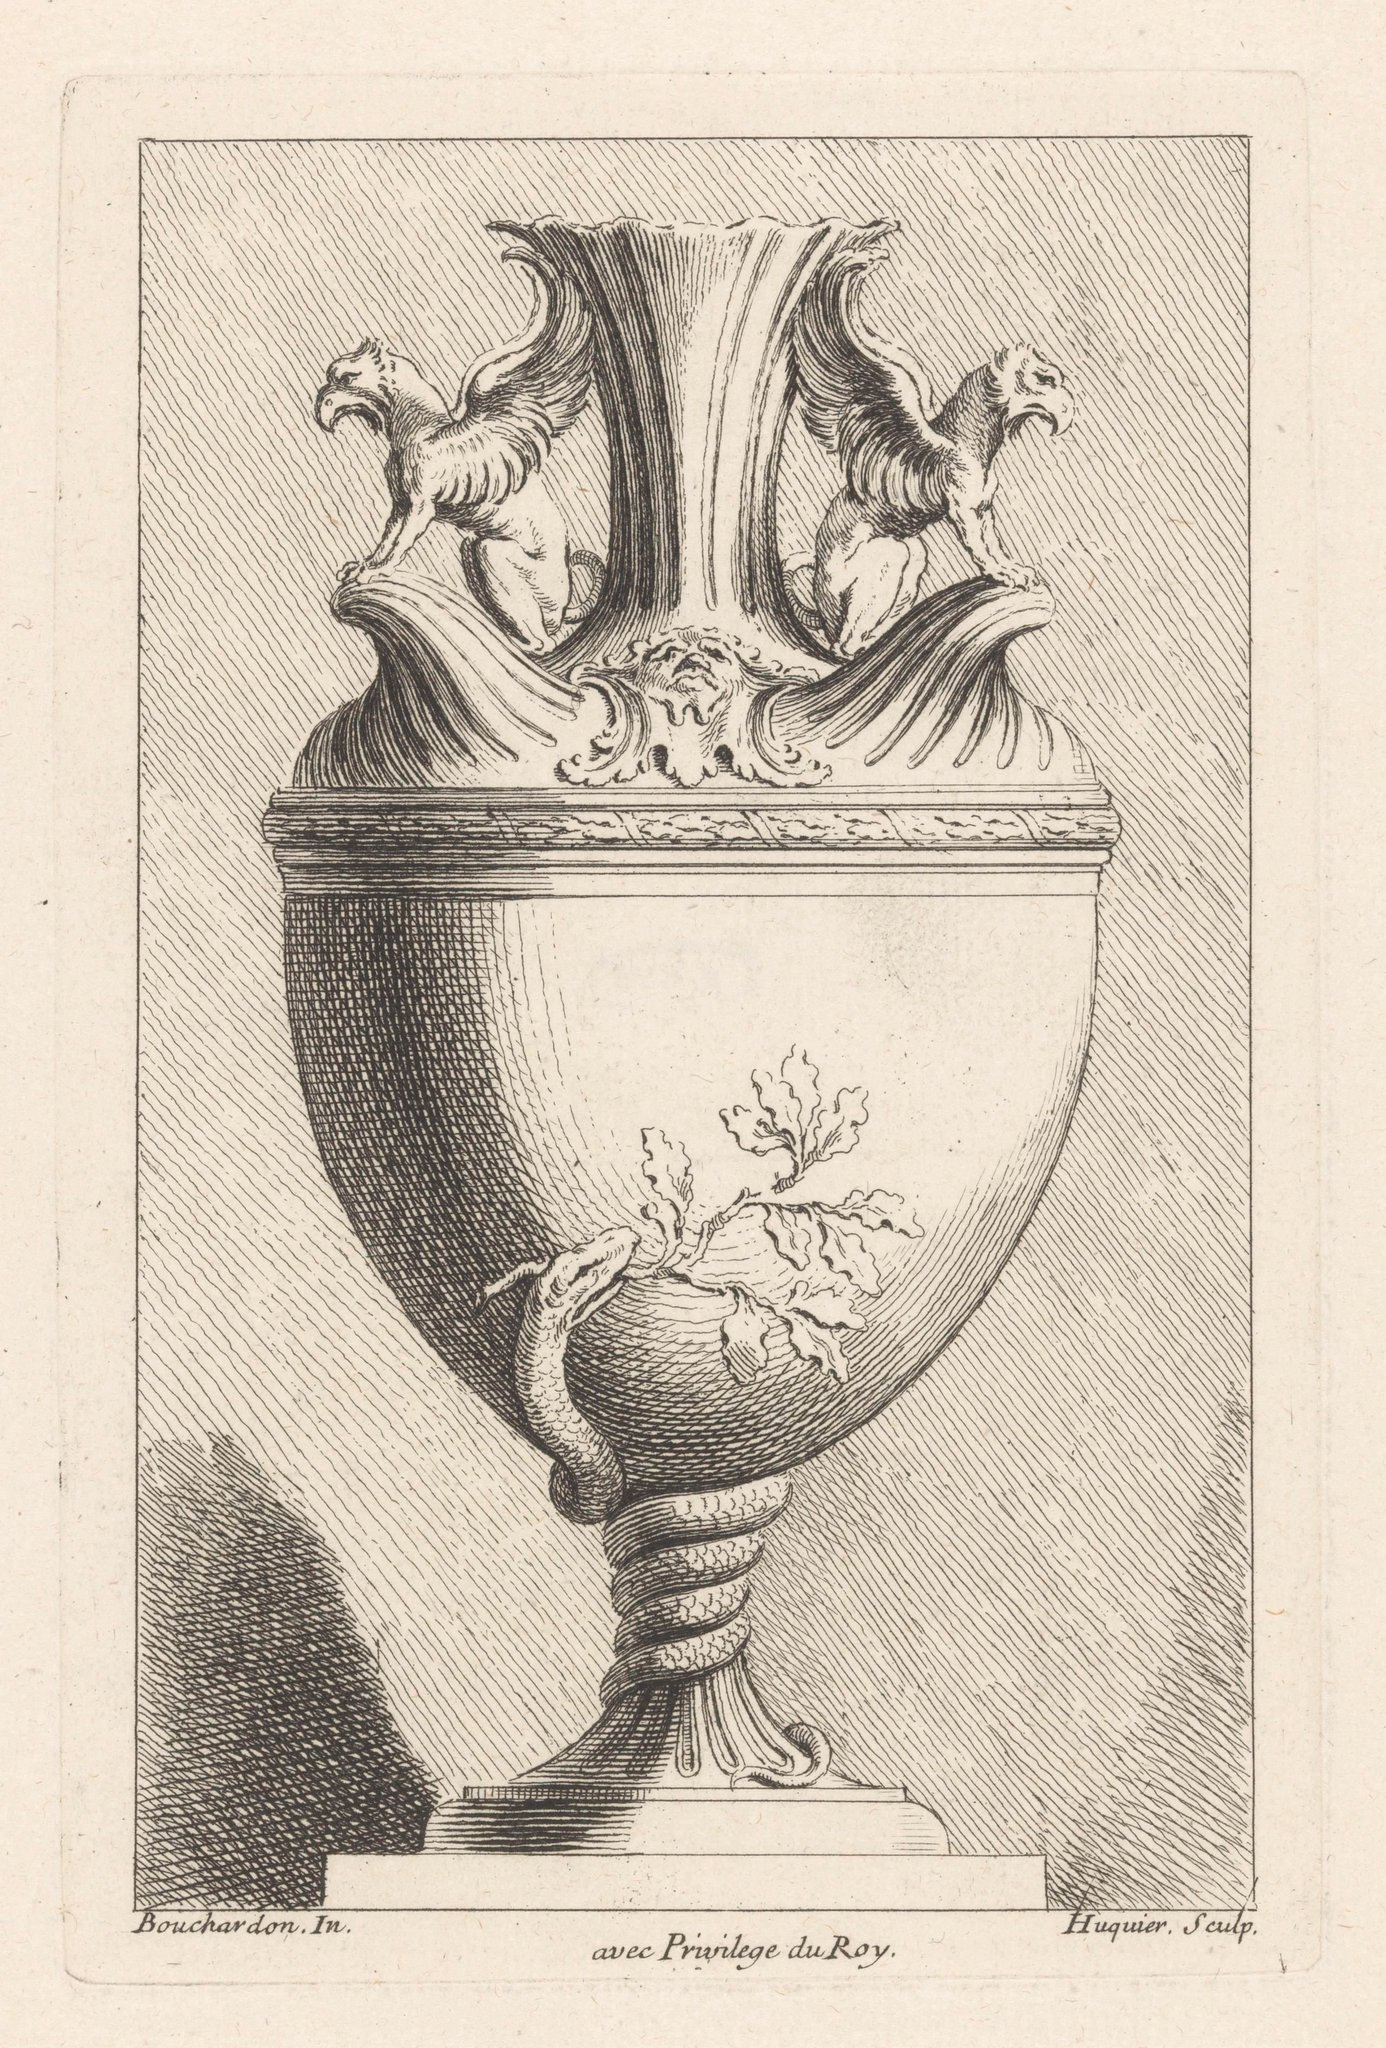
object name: ornament print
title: Second livre de vases (...)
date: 1729-1737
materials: paper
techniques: etching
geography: paris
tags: snakes, griffin (lion/eagle); 'griffo' (ripa), vase ~ ornament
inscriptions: collector's mark: Lugt 2228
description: Een vaas met twee griffioenen en een slang.